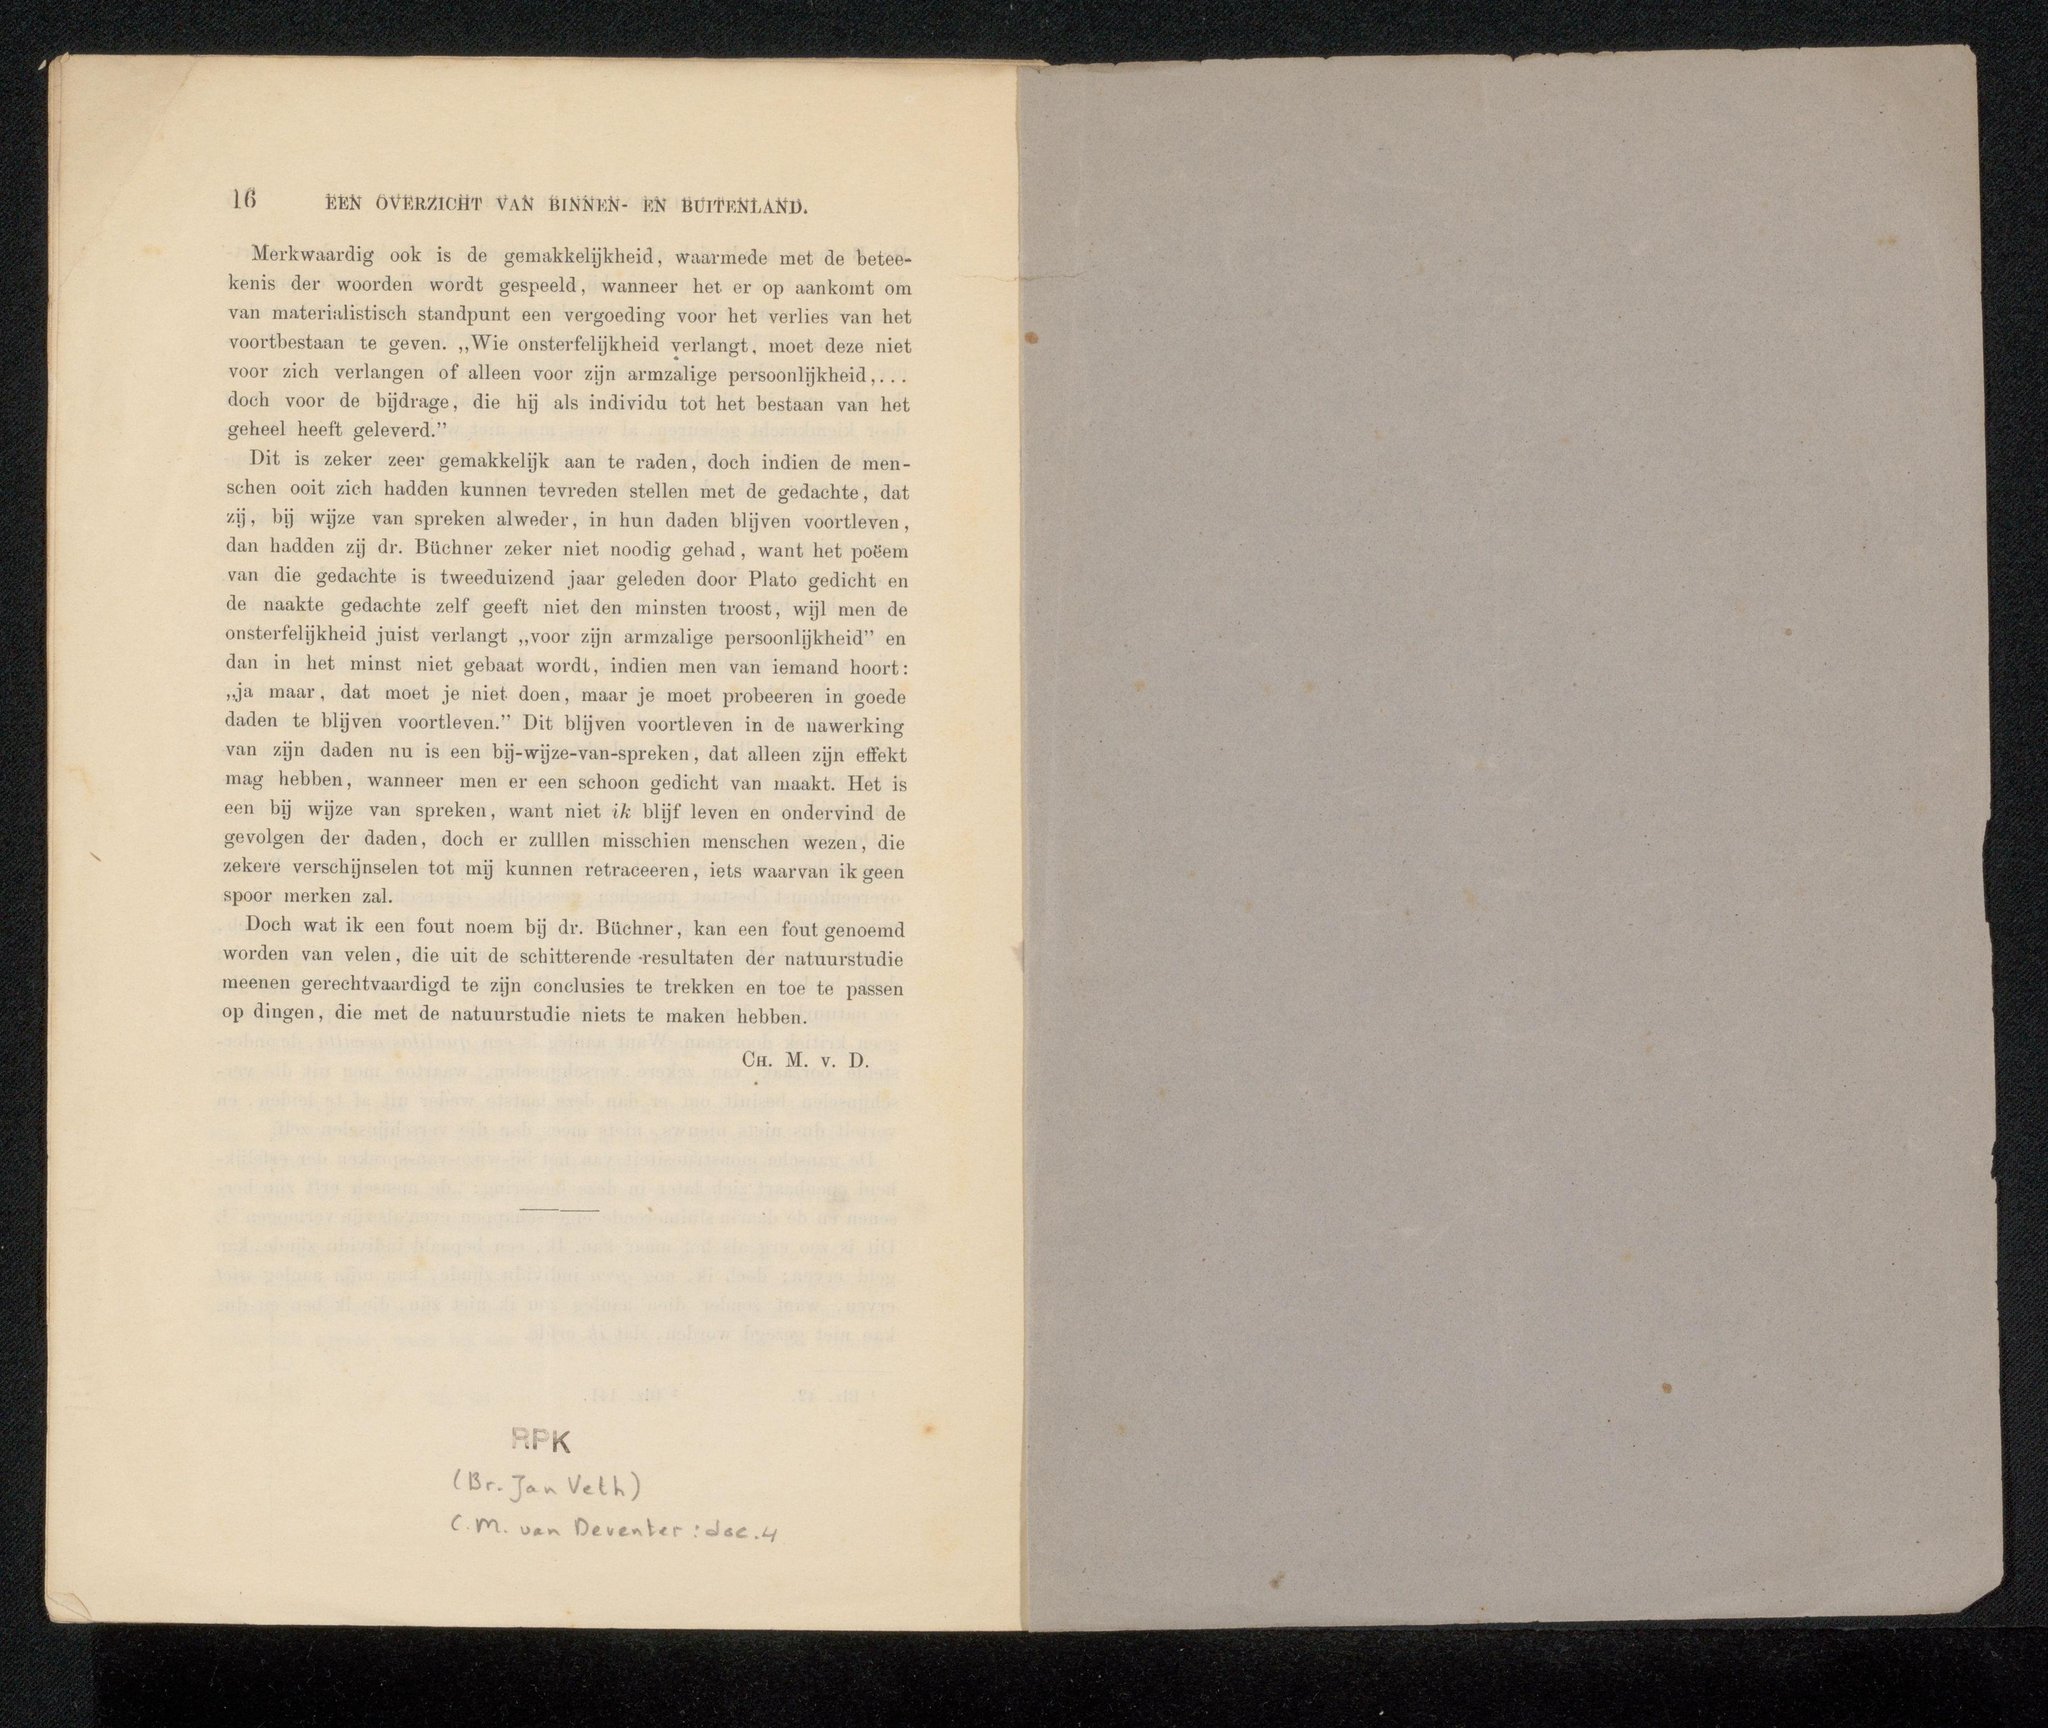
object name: article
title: Artikel uit archief Jan Veth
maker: chap van deventer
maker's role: kunstcriticus, scheikundige, schrijver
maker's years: 1860-1931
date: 1870-1931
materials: cardboard, paper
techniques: pen, printing, writing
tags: dordrecht, painter, print maker, draughtsman, designer, jan veth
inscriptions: collector's mark: ‘RPK’, name: ‘JAN VETH’, bookplate: ‘EX LIBRIS DELPRAT VETH 1915’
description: Artikel bevat aantekening op een los kaartje.